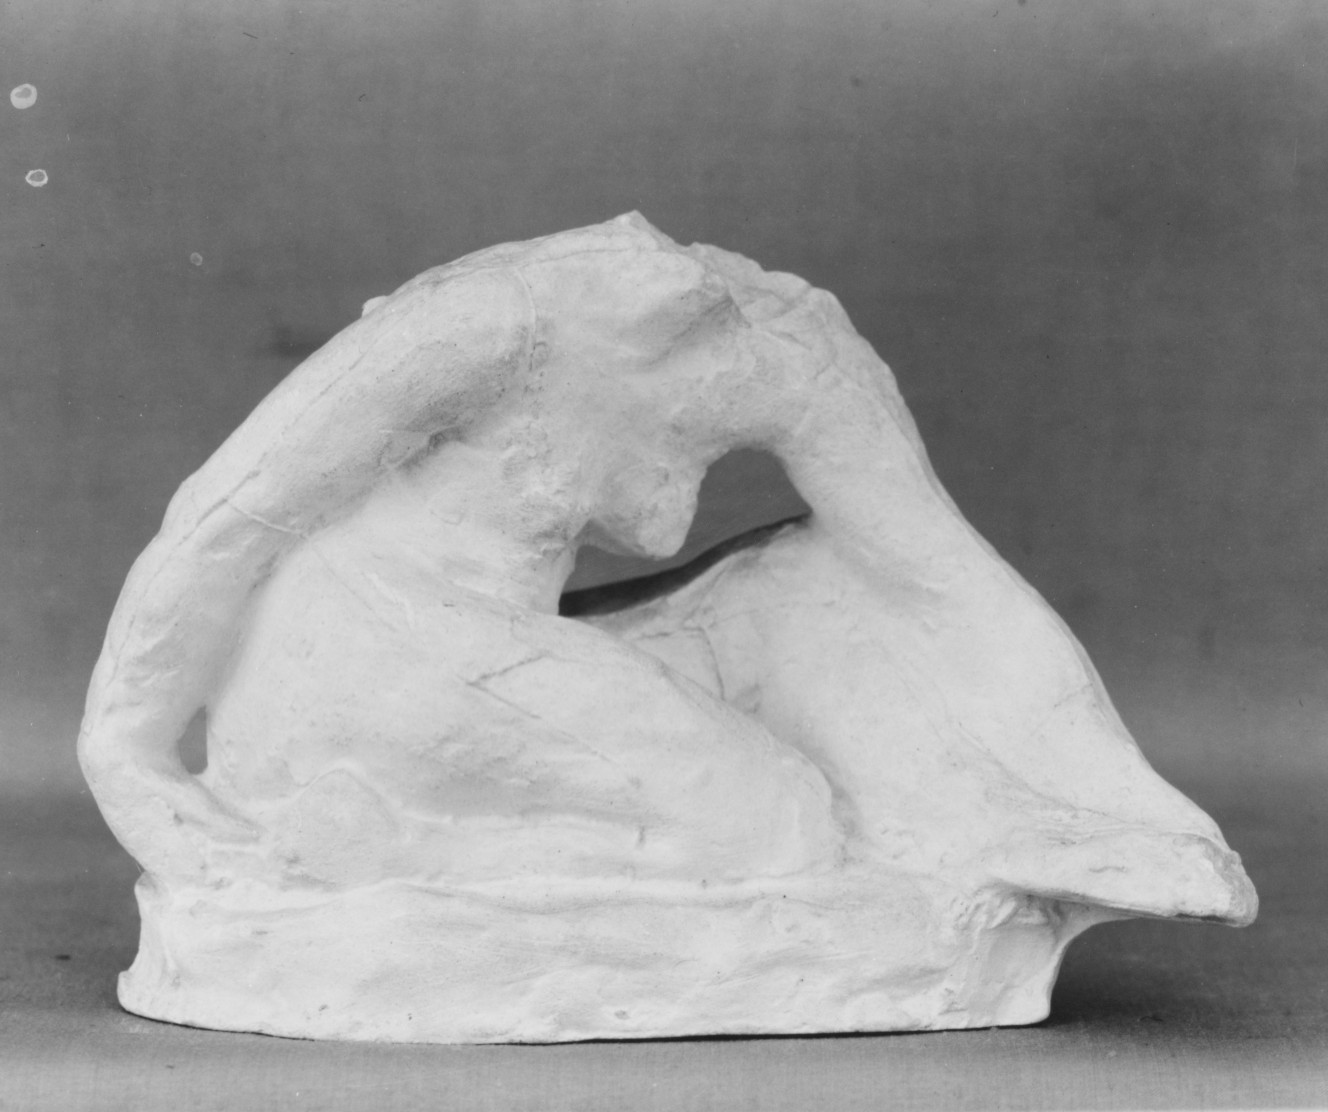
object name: cast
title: Young woman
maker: auguste rodin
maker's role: artist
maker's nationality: french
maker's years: 1840-1917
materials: plaster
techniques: casting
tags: women